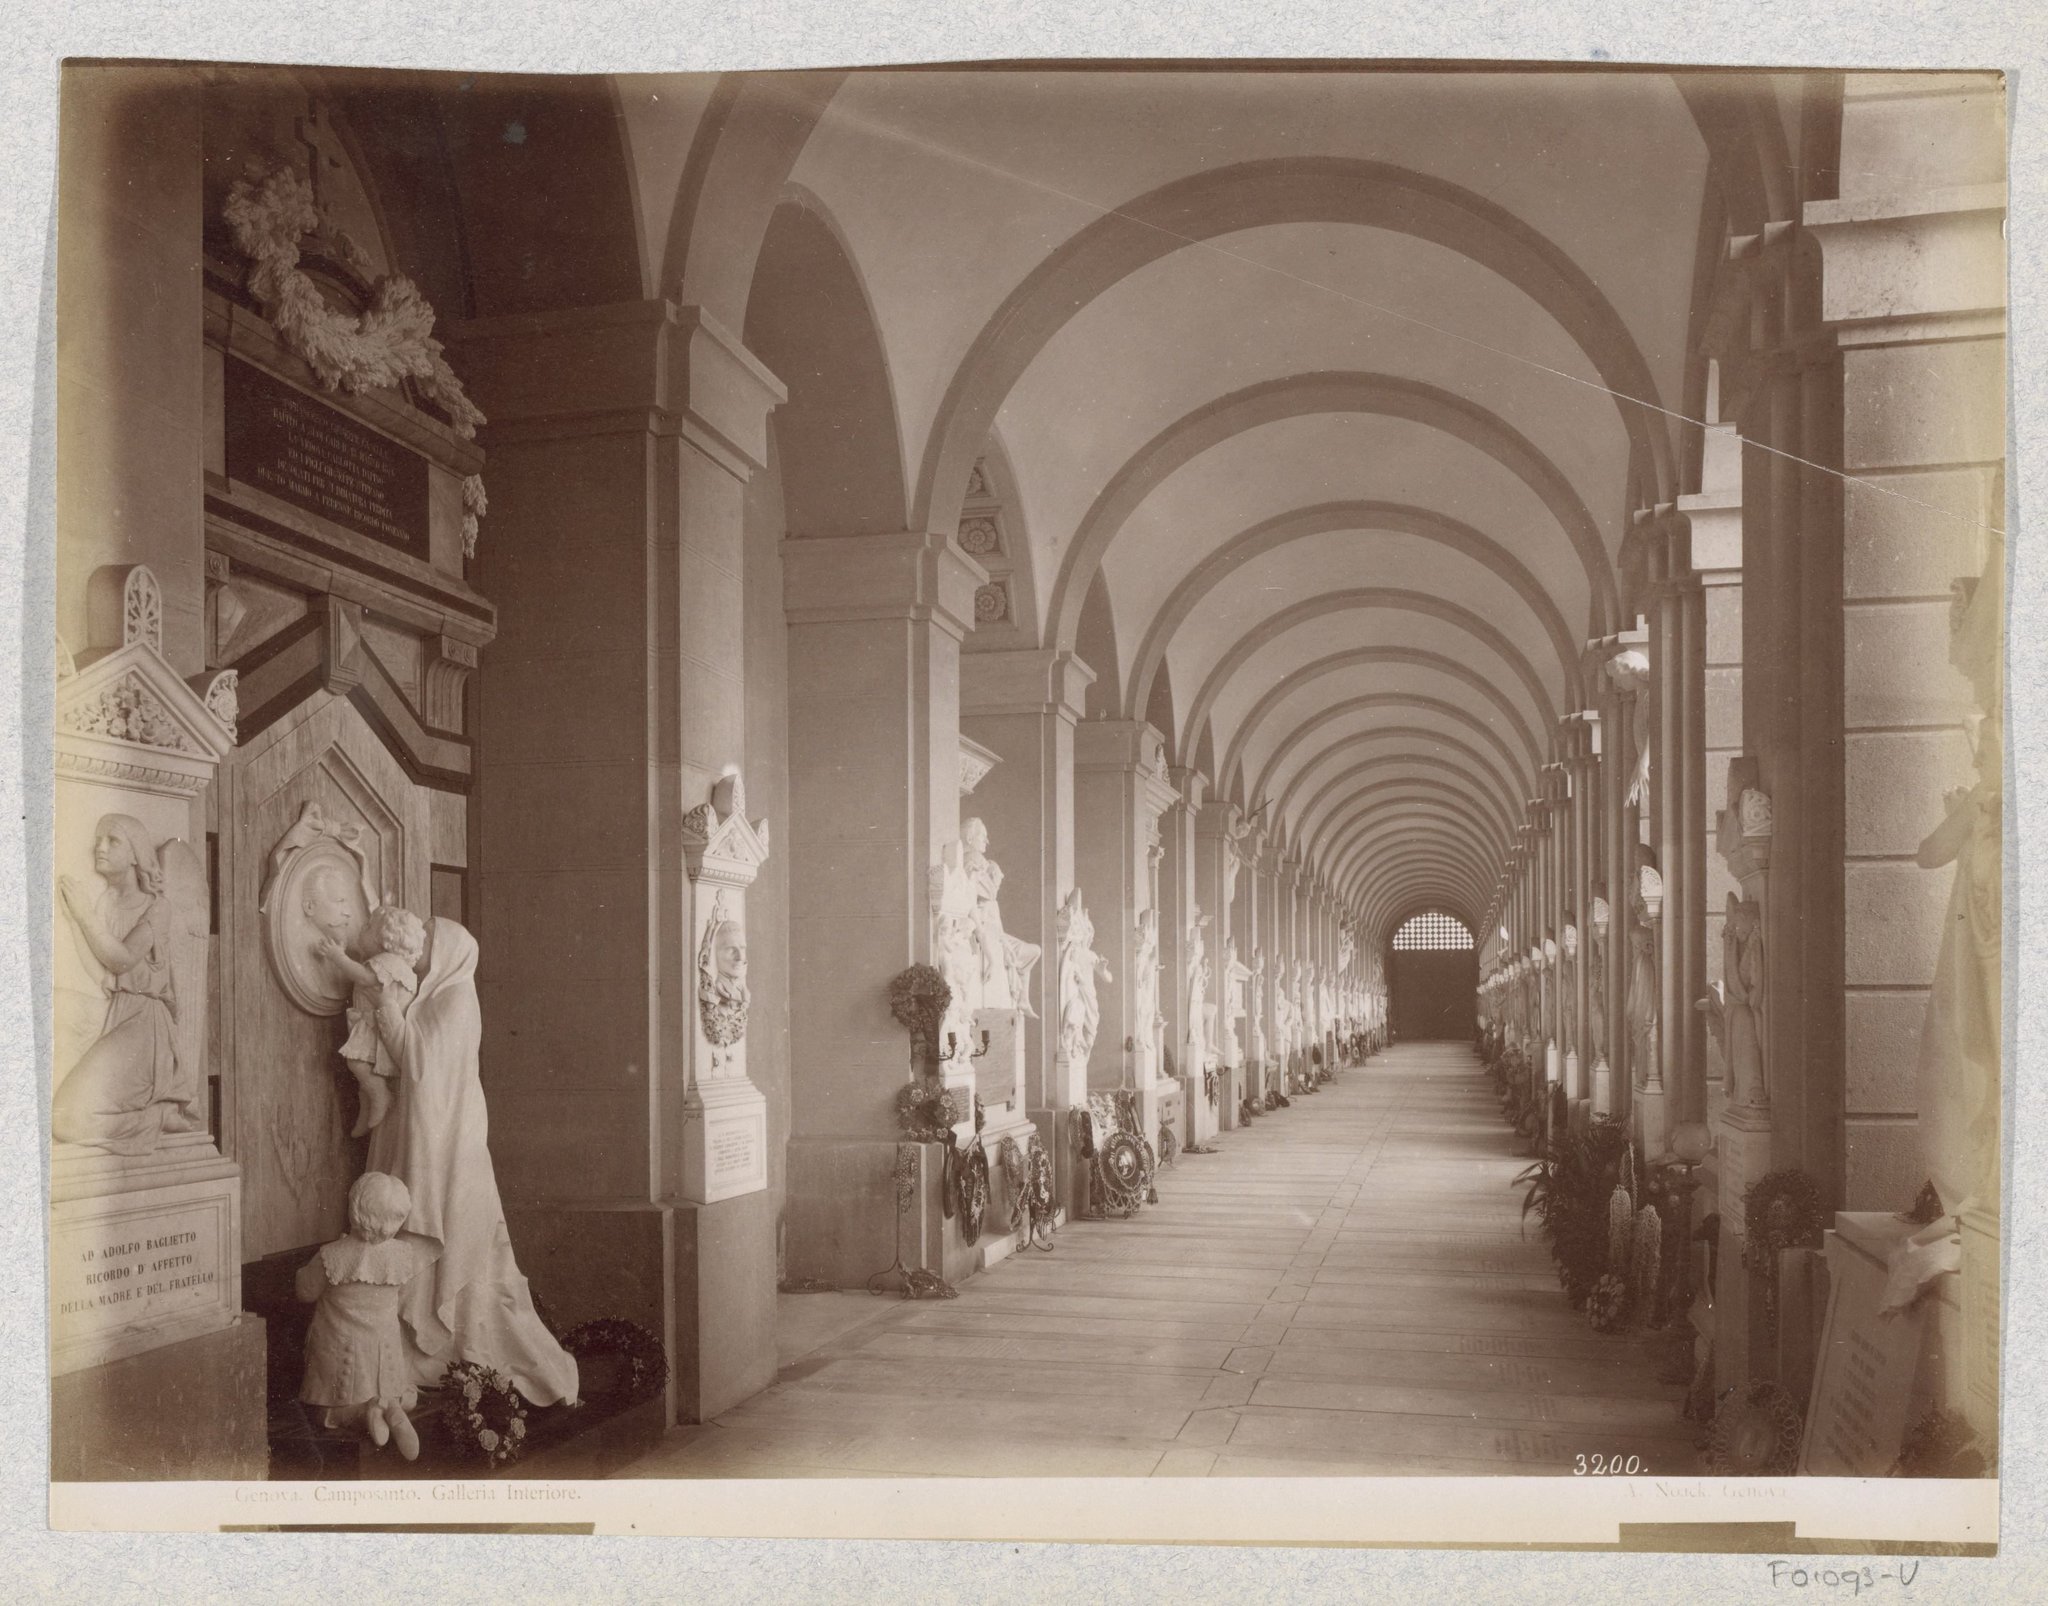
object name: photograph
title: Interieur van een galerij op de begraafplaats van Staglieno in Genua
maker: alfredo noack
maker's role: fotograaf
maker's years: 1833-1895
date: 1870-1890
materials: paper, photographic support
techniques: albumen print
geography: genoa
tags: gallery (spacious corridor), cemetery, park-like burying ground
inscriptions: negative number: ‘3200’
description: Onderdeel van Reisalbum met foto's van bezienswaardigheden in Genua, Florence en Venetië.